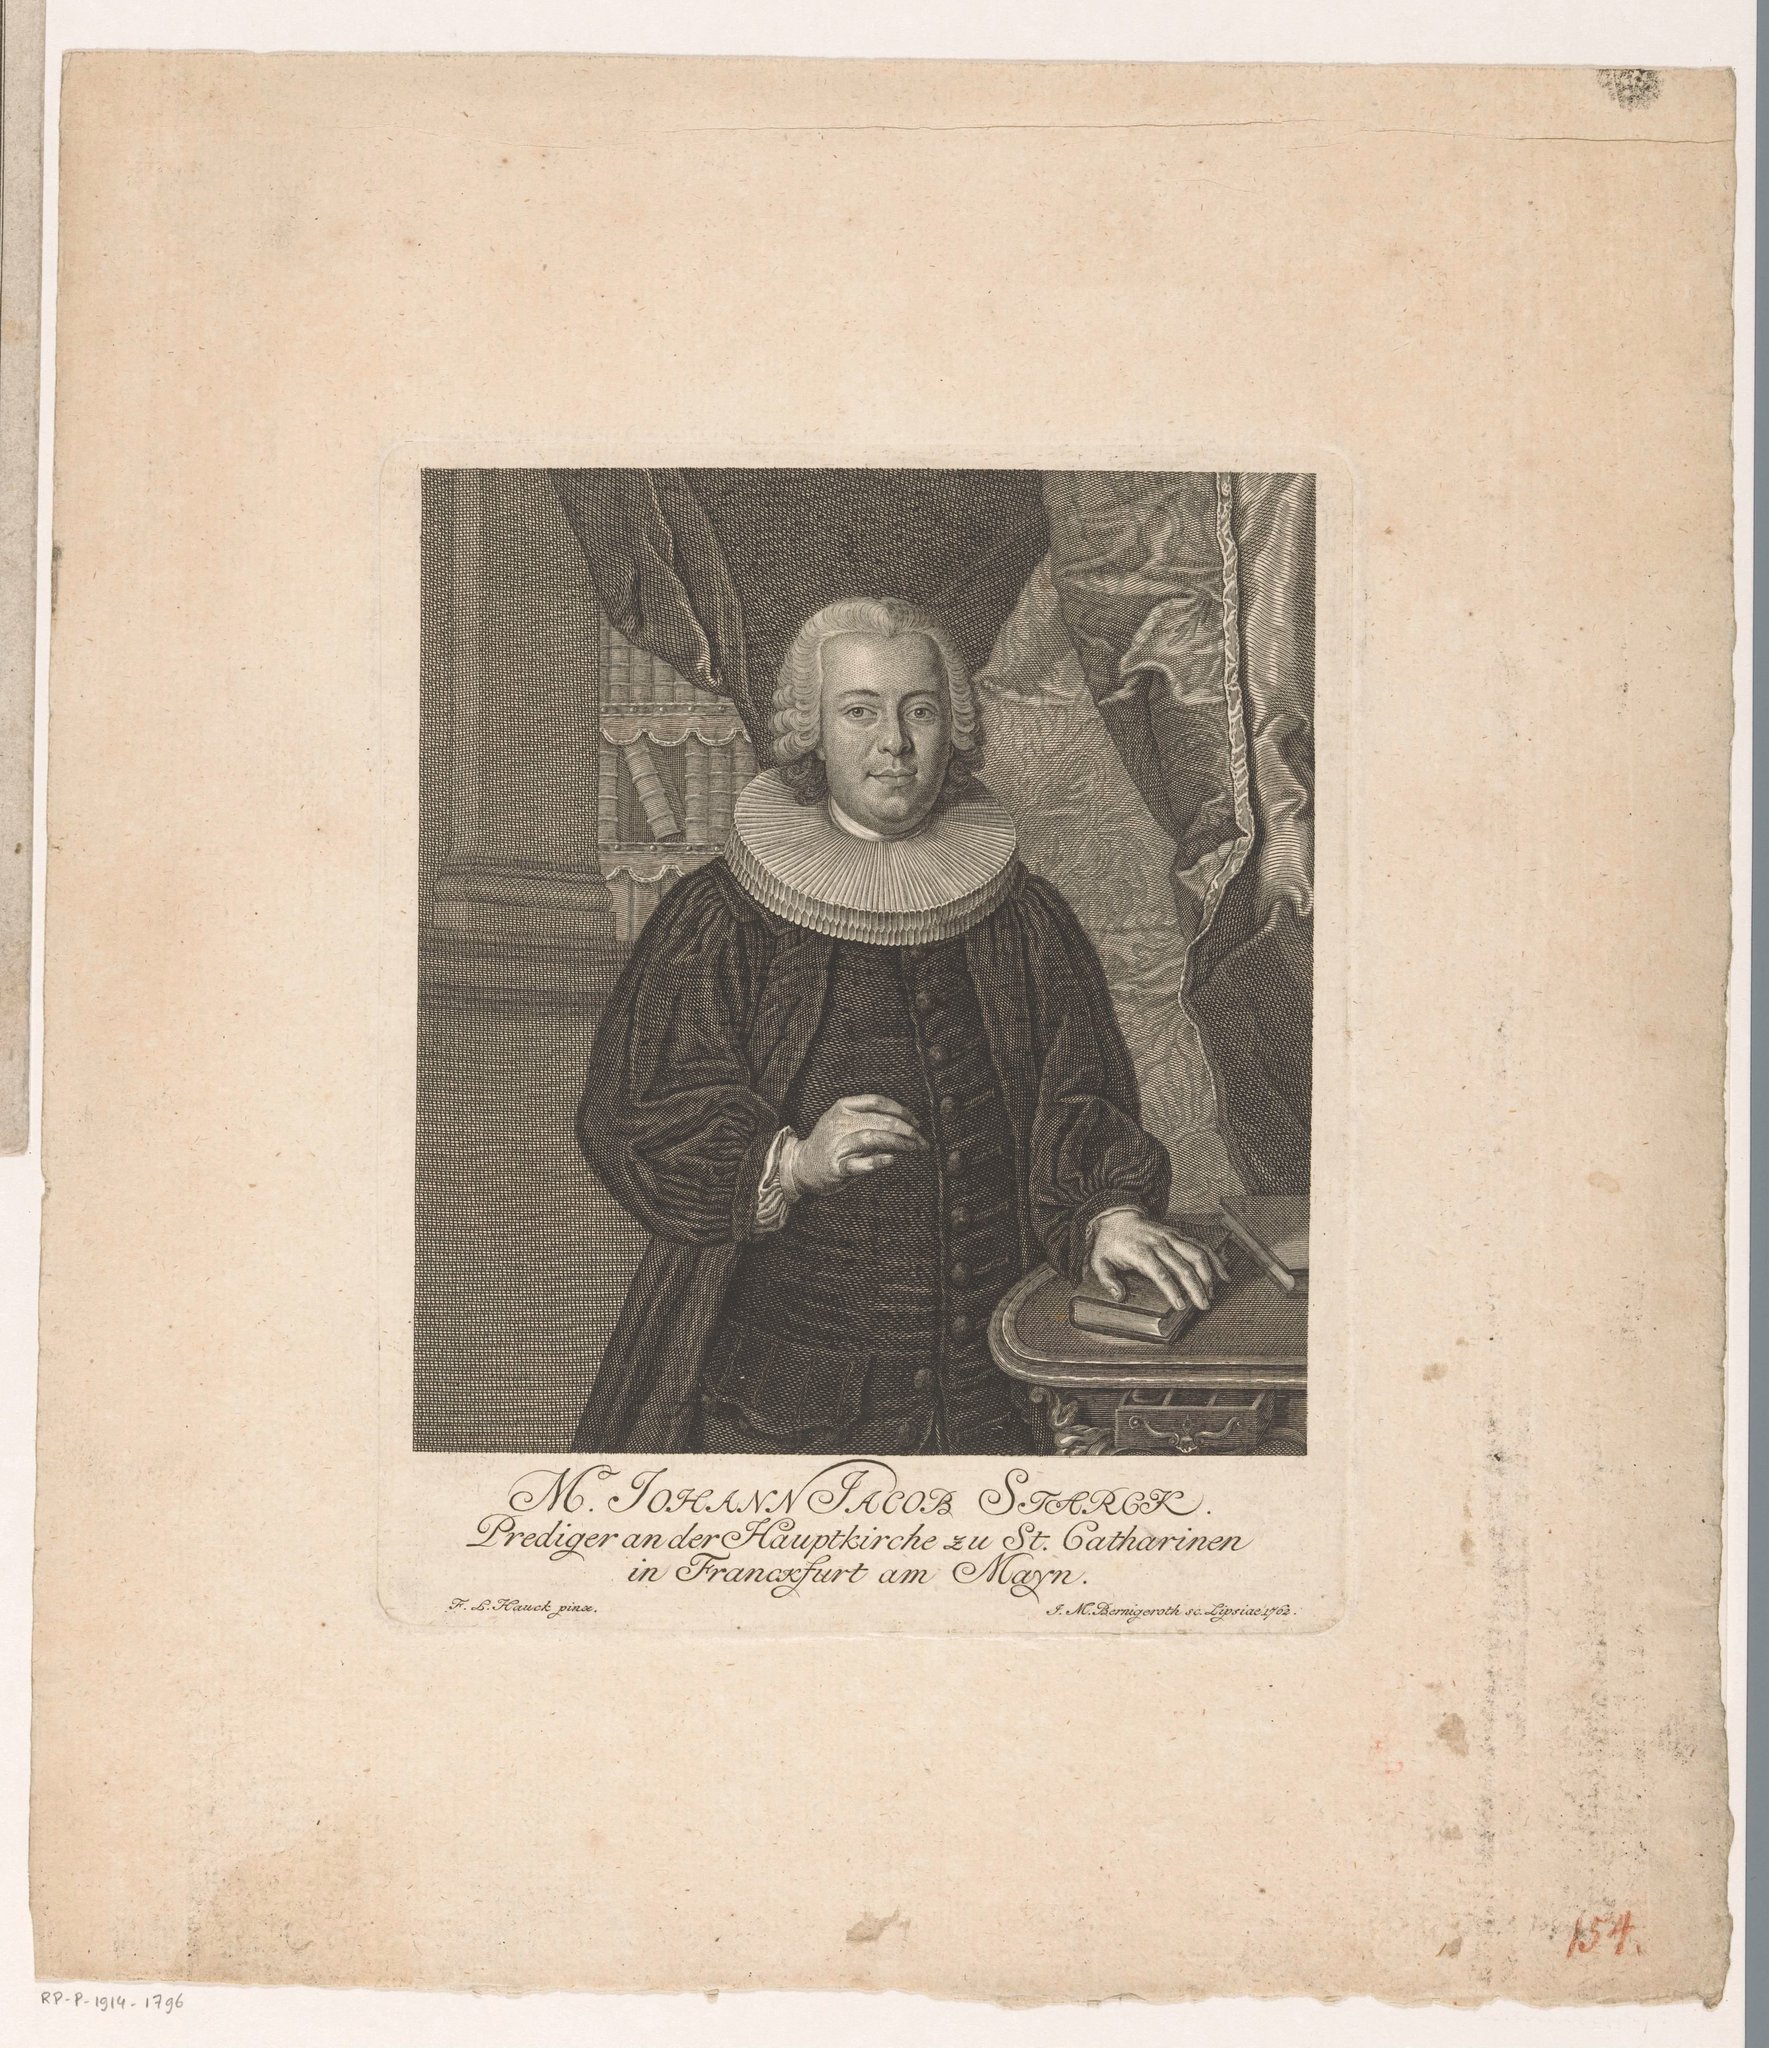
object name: print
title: Portret van Johann Jacob Starck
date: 1762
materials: paper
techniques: engraving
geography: leipzig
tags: bookshelves, historical persons, book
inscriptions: collector's mark: Lugt 2228